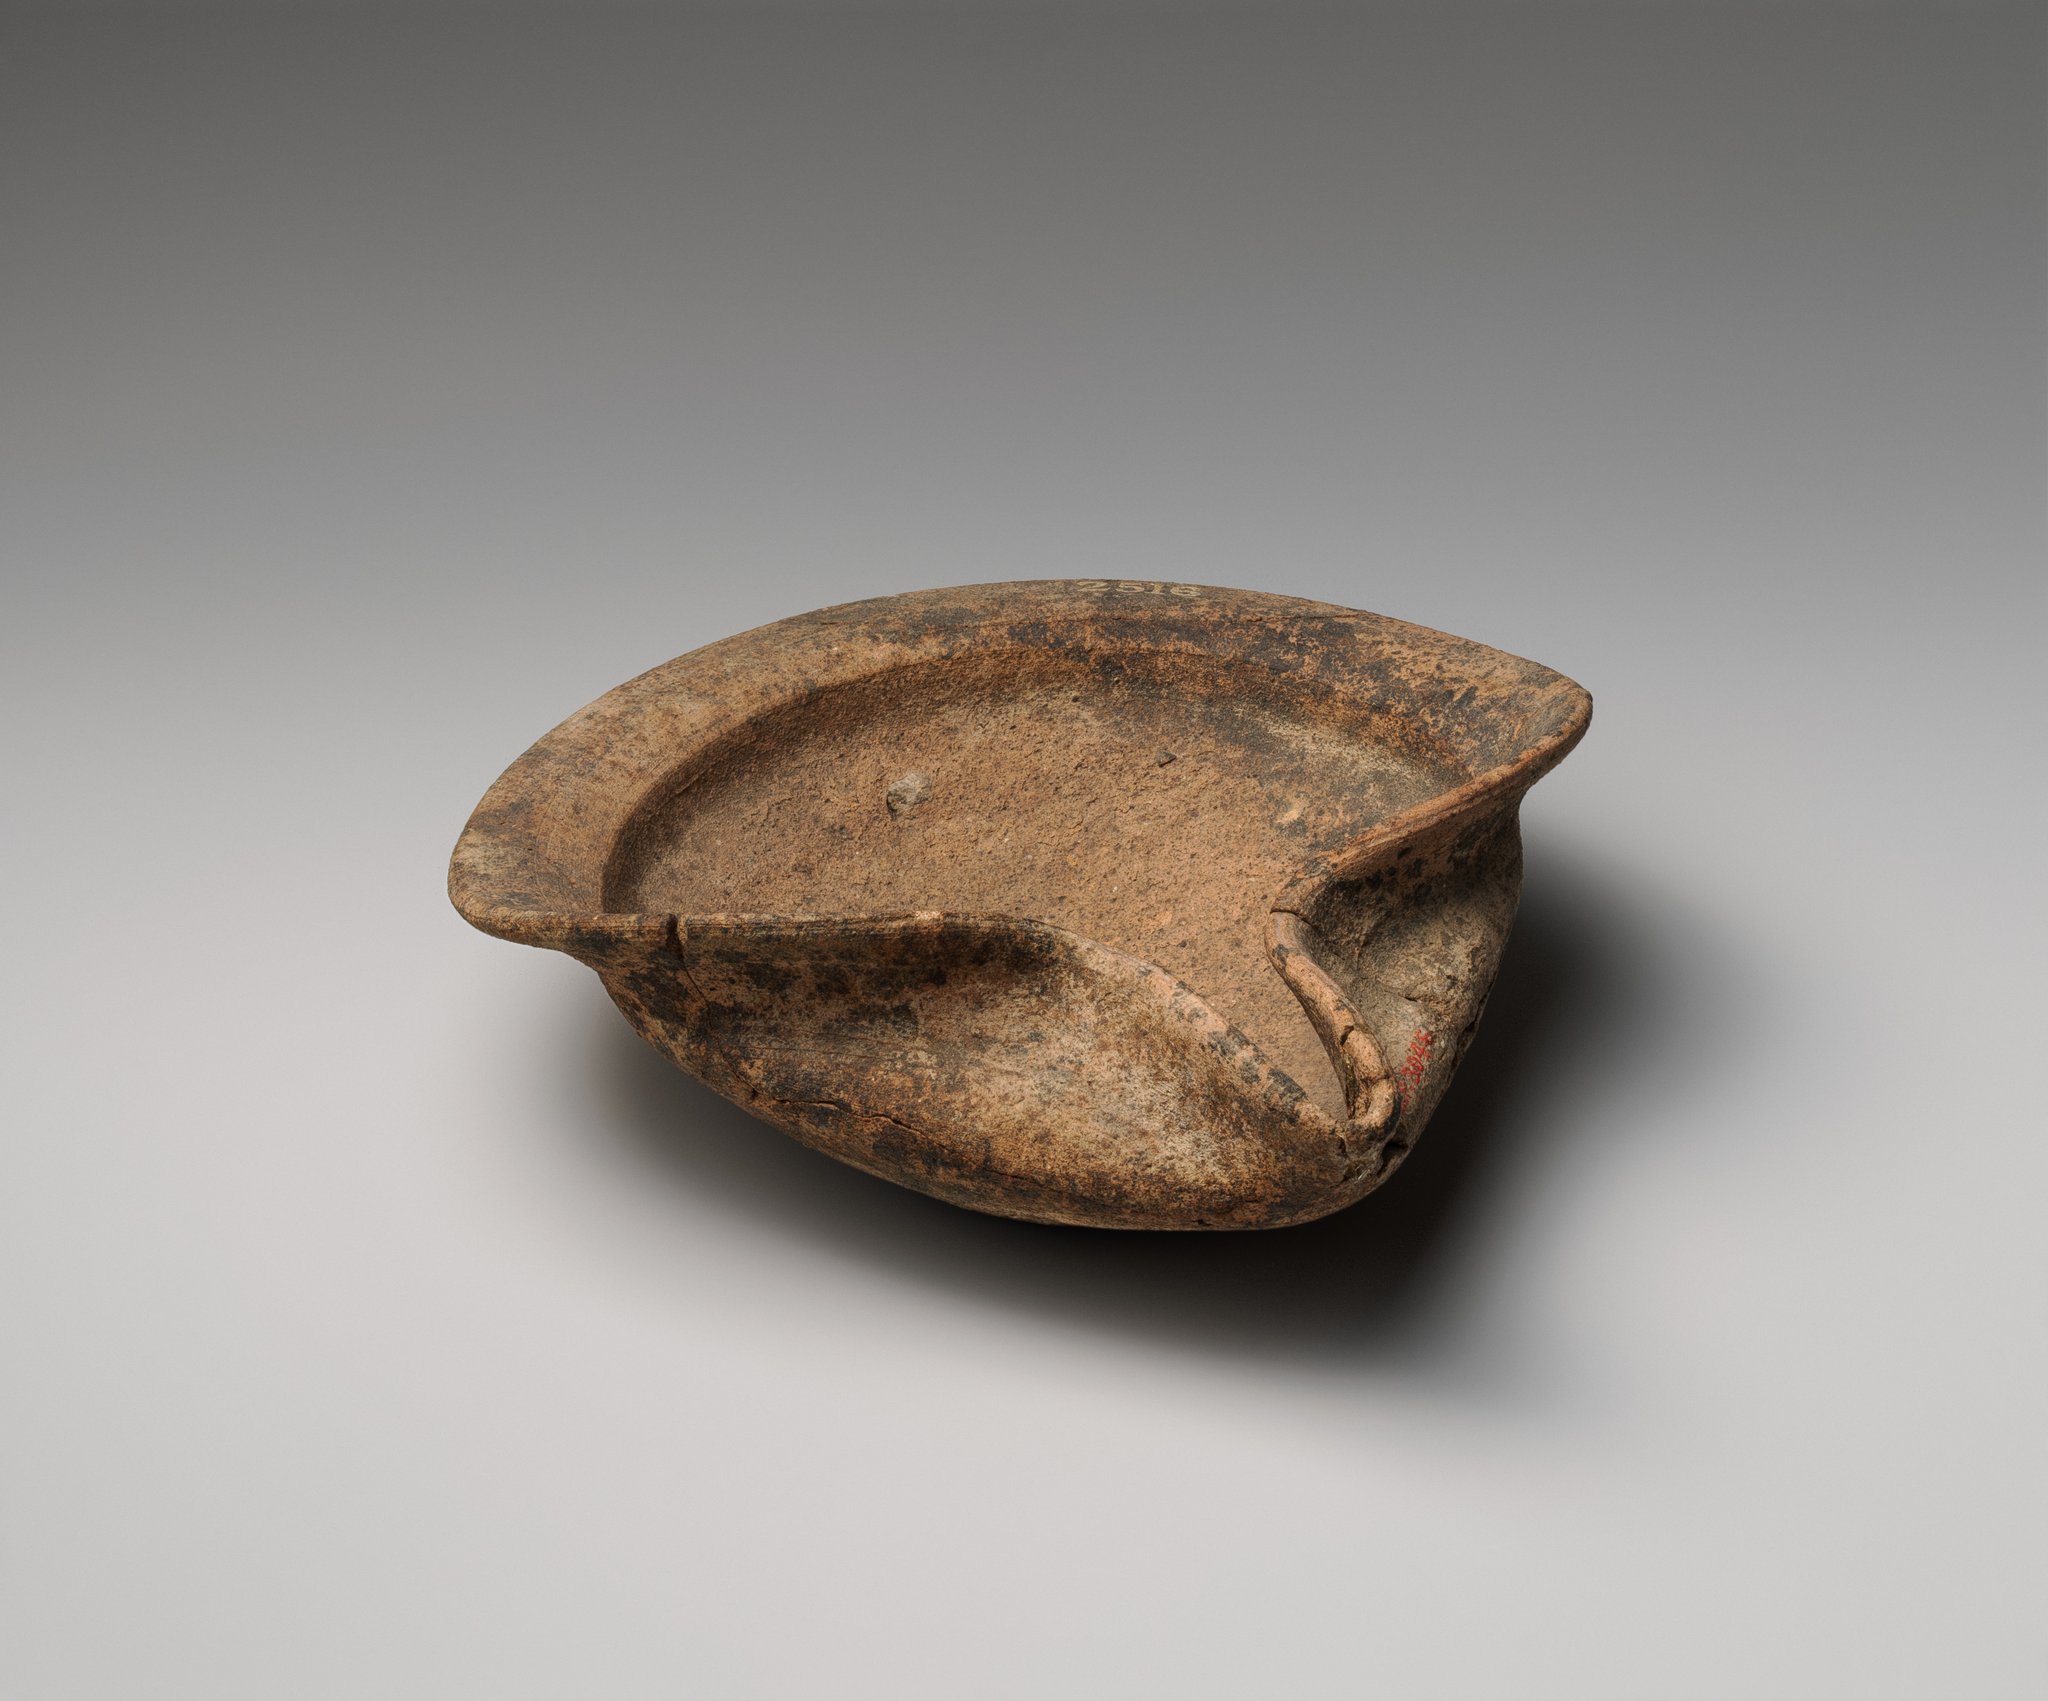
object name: lamp, saucer shaped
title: Terracotta saucer-shaped lamp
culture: cypriot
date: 400-301 BCE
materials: terracotta